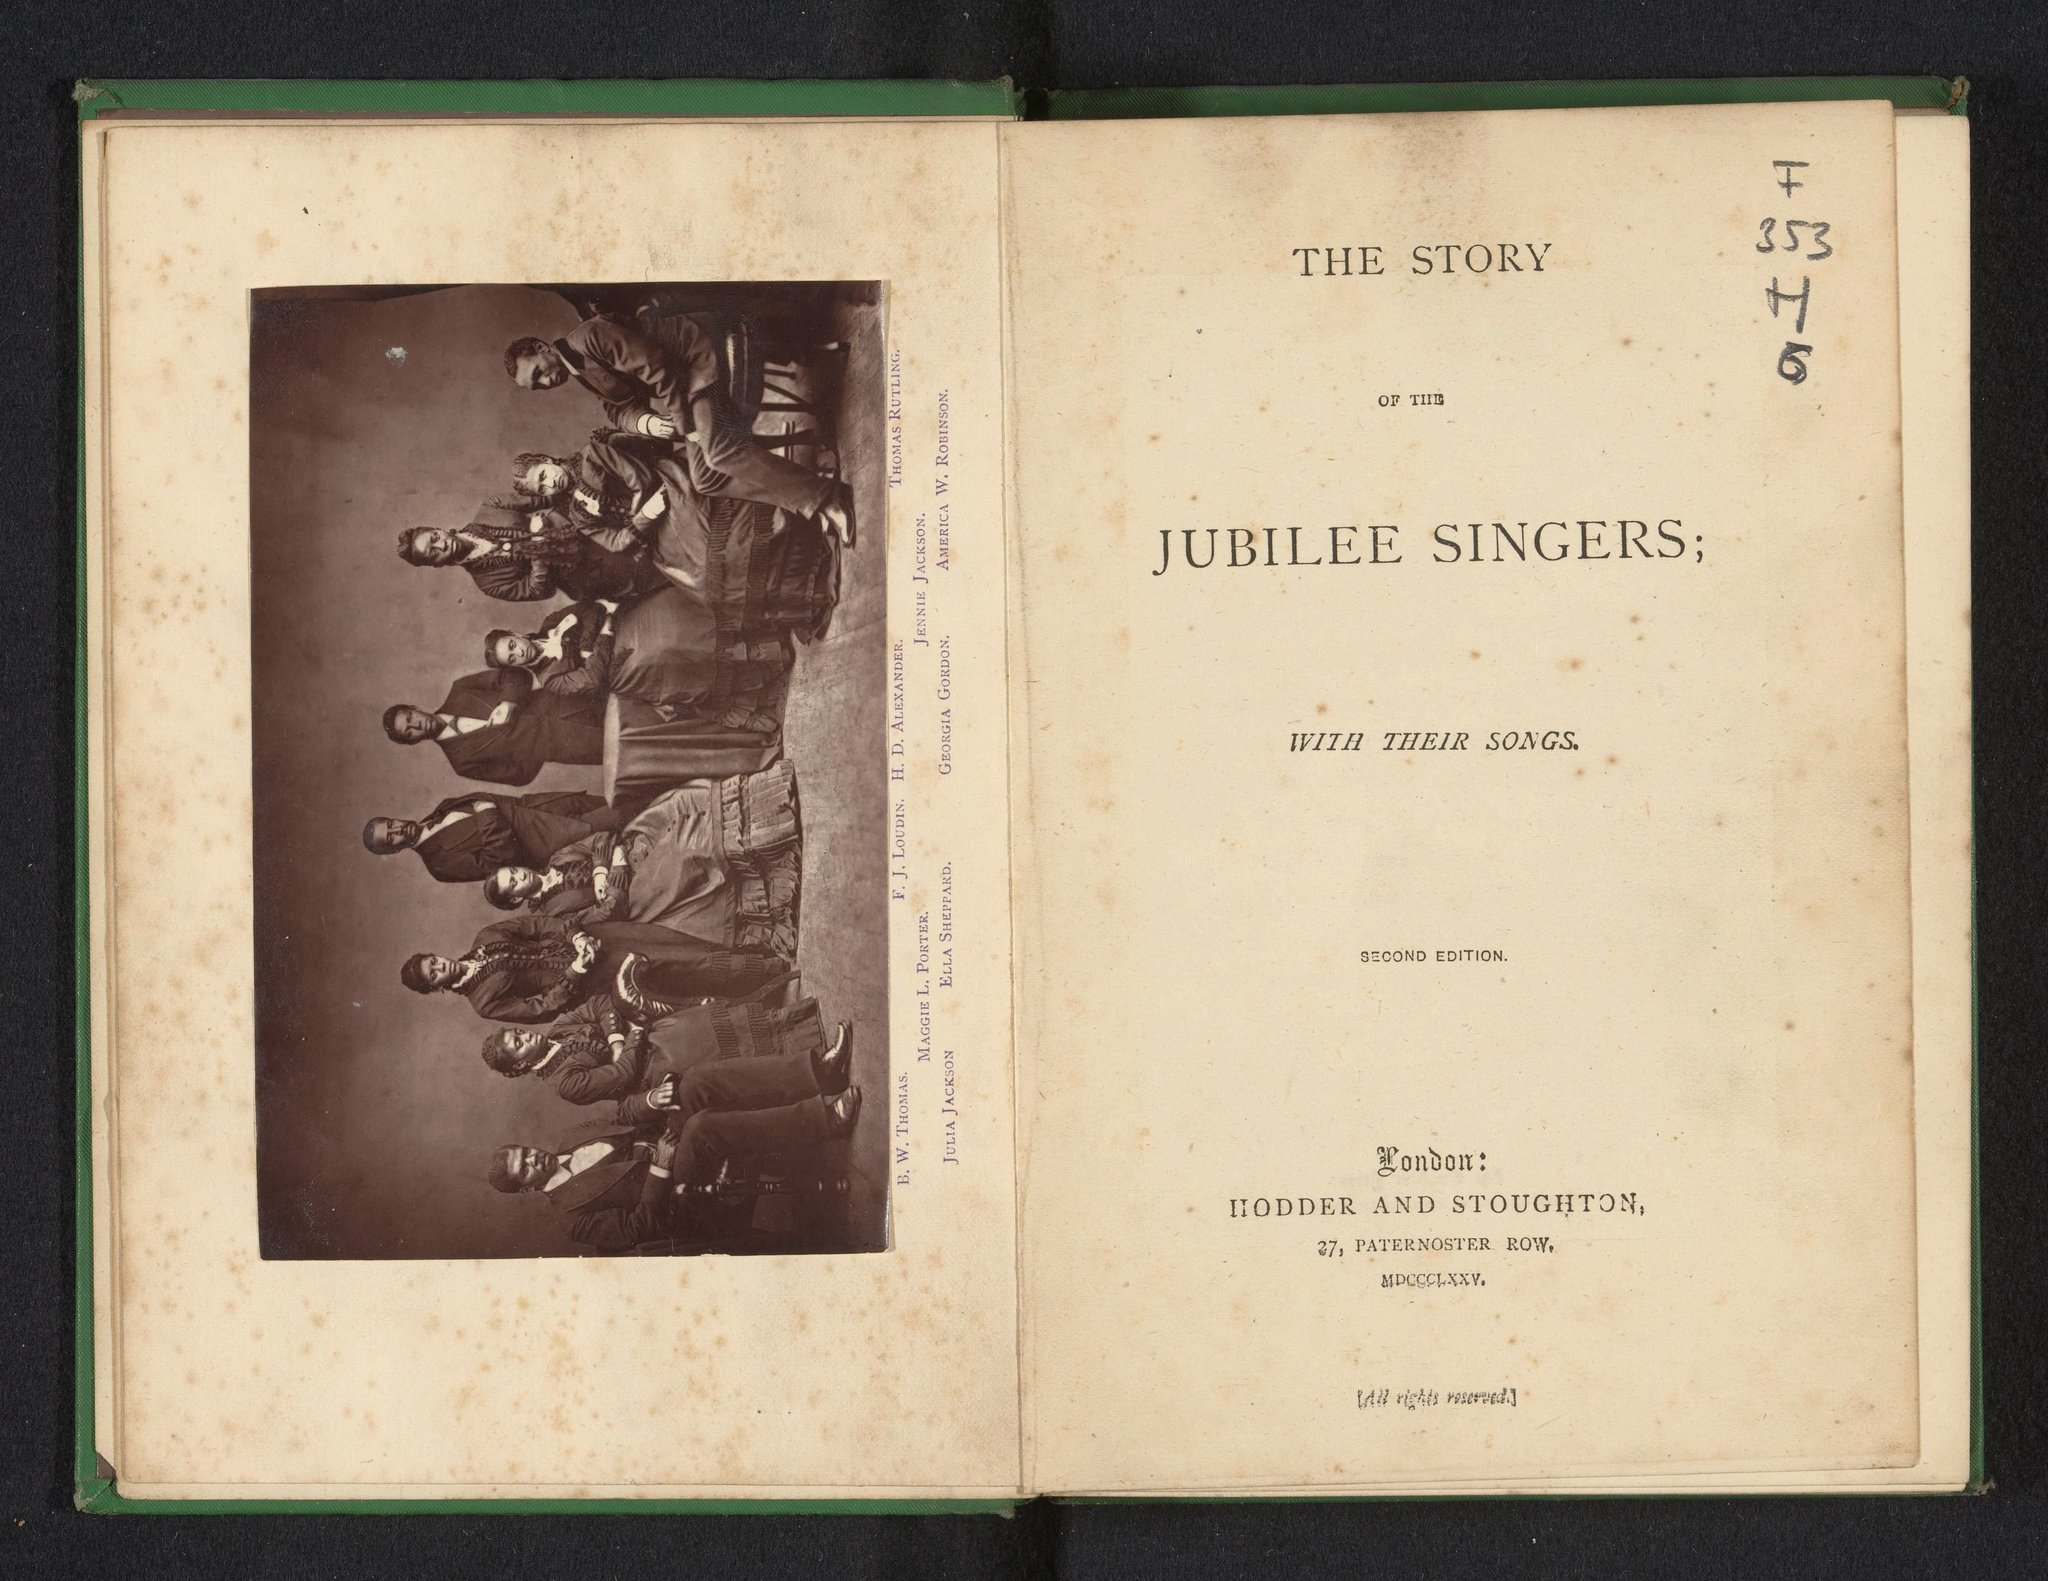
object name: book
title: The story of the Jubilee Singers with their songs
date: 1875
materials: cardboard, linen, paper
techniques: printing, woodburytype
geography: london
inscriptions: inscription: ‘Headingley Hill Congregational Church Sunday School Library No. 643’, inscription: ‘ex libris SFJ’, inscription: ‘Presented by Mrs J. Nussey’